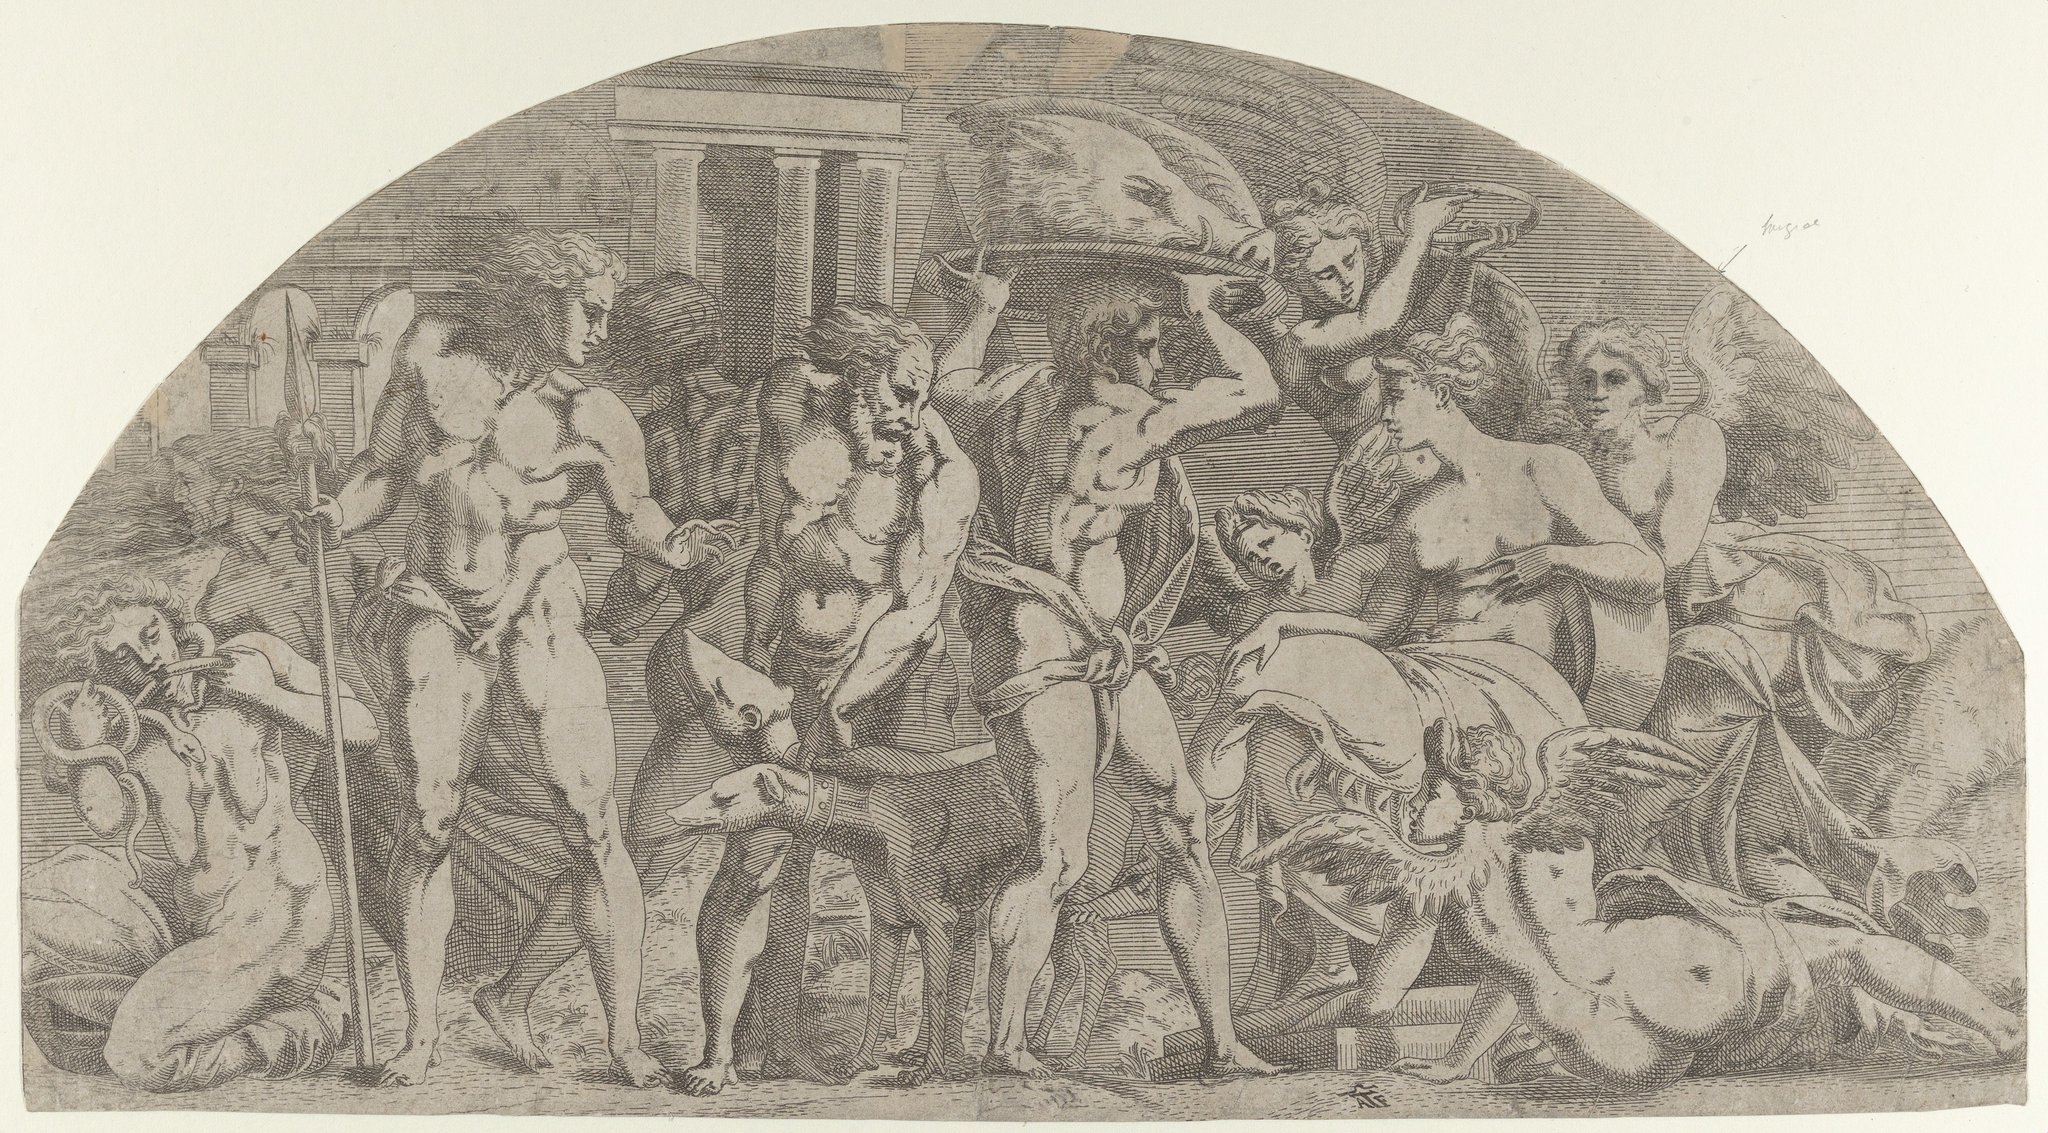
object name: print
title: Meleager Bringing the Boar's Head to Atalanta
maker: antonio fantuzzi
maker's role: artist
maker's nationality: italian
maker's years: 1537-1545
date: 1540-1545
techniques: etching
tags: men,male nudes,women,boars,dogs